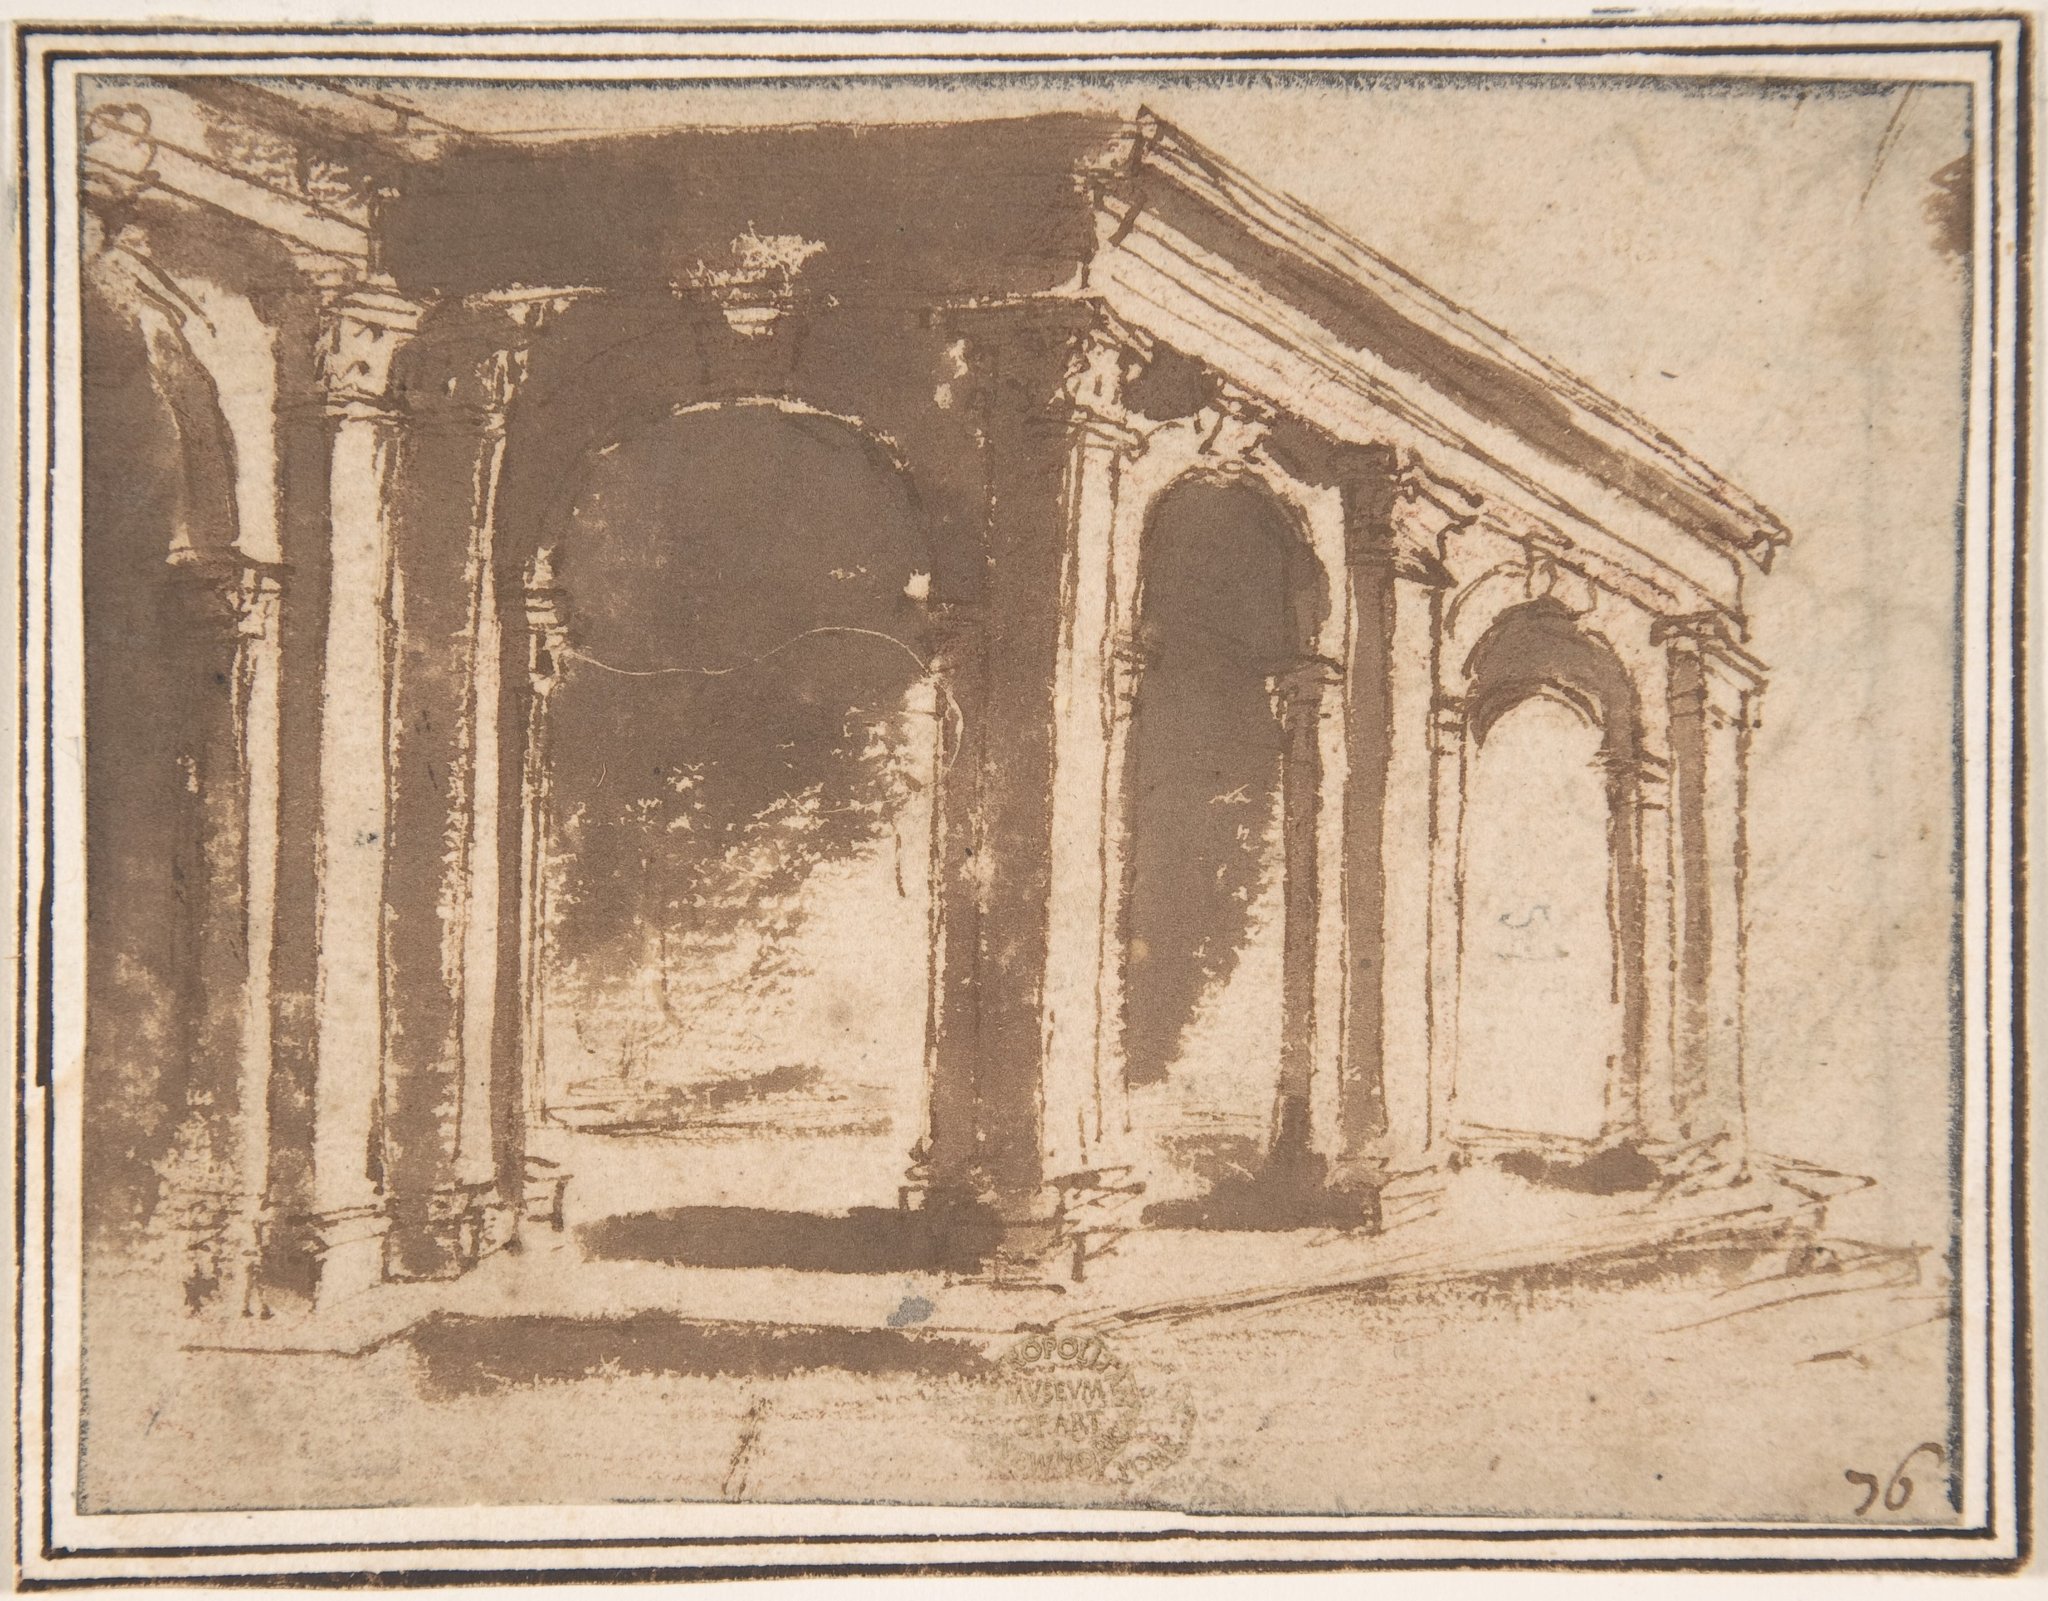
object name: drawing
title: Loggia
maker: anonymous, italian, roman-bolognese, 17th century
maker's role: artist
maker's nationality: italian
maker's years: 1600-1700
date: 1601-1700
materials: chalk, ink, paper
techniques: brush, pen, wash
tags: arches